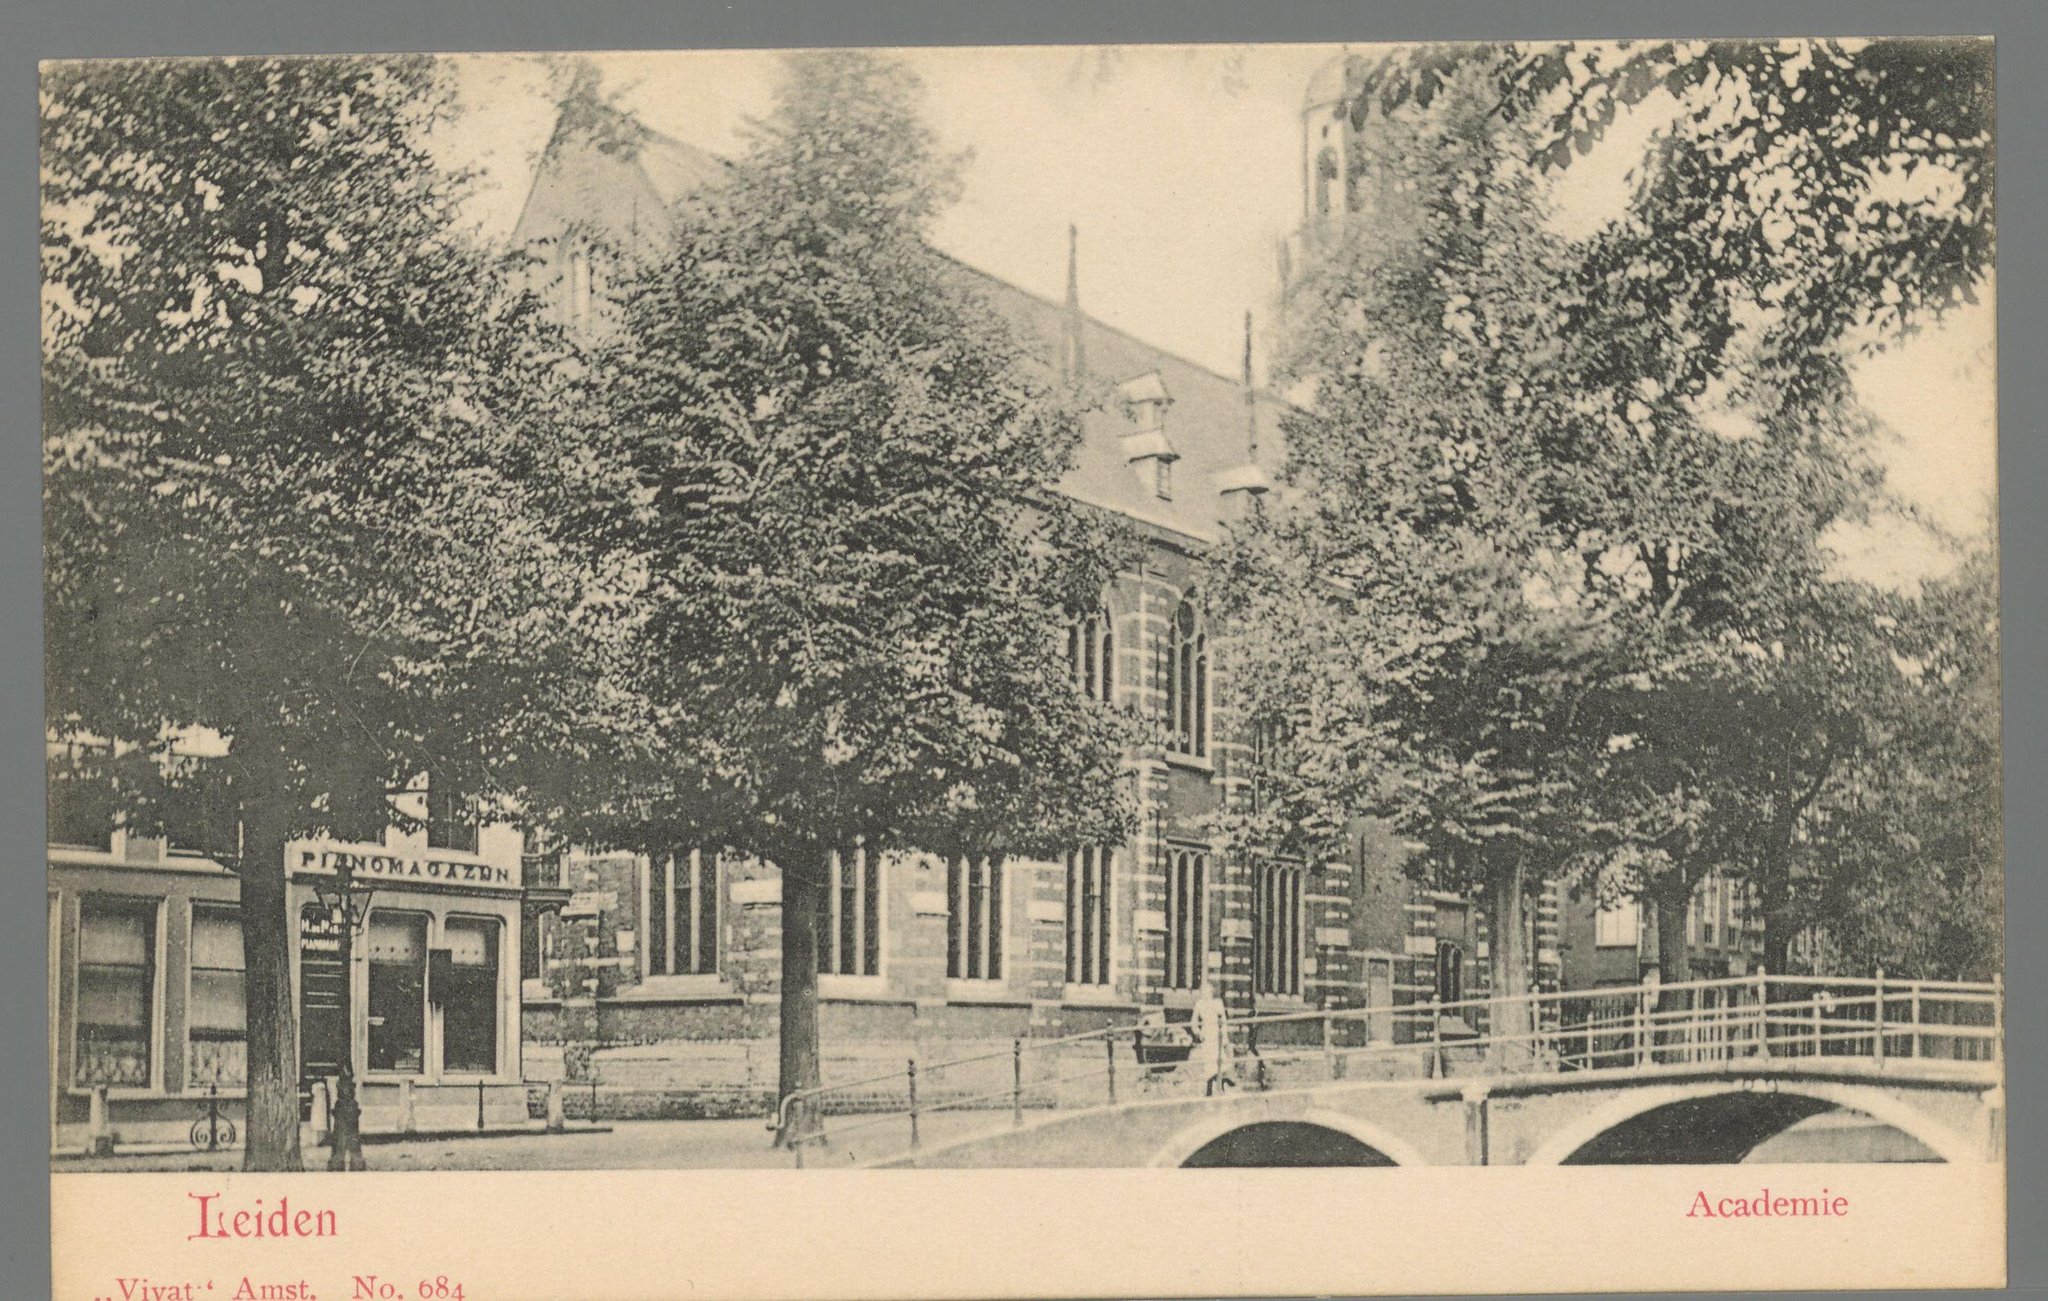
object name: photomechanical print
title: Leiden. Academie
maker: Anonymous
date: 1897-1905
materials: cardboard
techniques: photograph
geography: leiden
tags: university building, college, bridge in city across river, canal, etc.